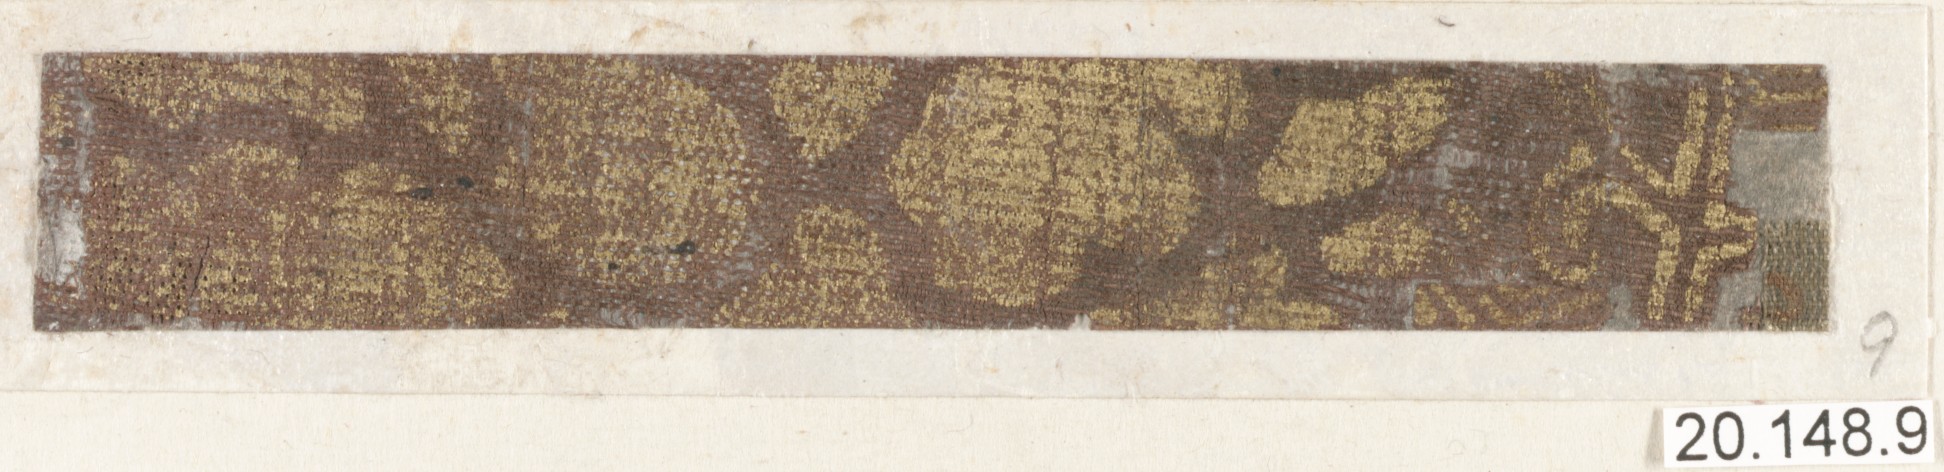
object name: piece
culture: japanese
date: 901-1000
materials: silk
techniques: compound weave